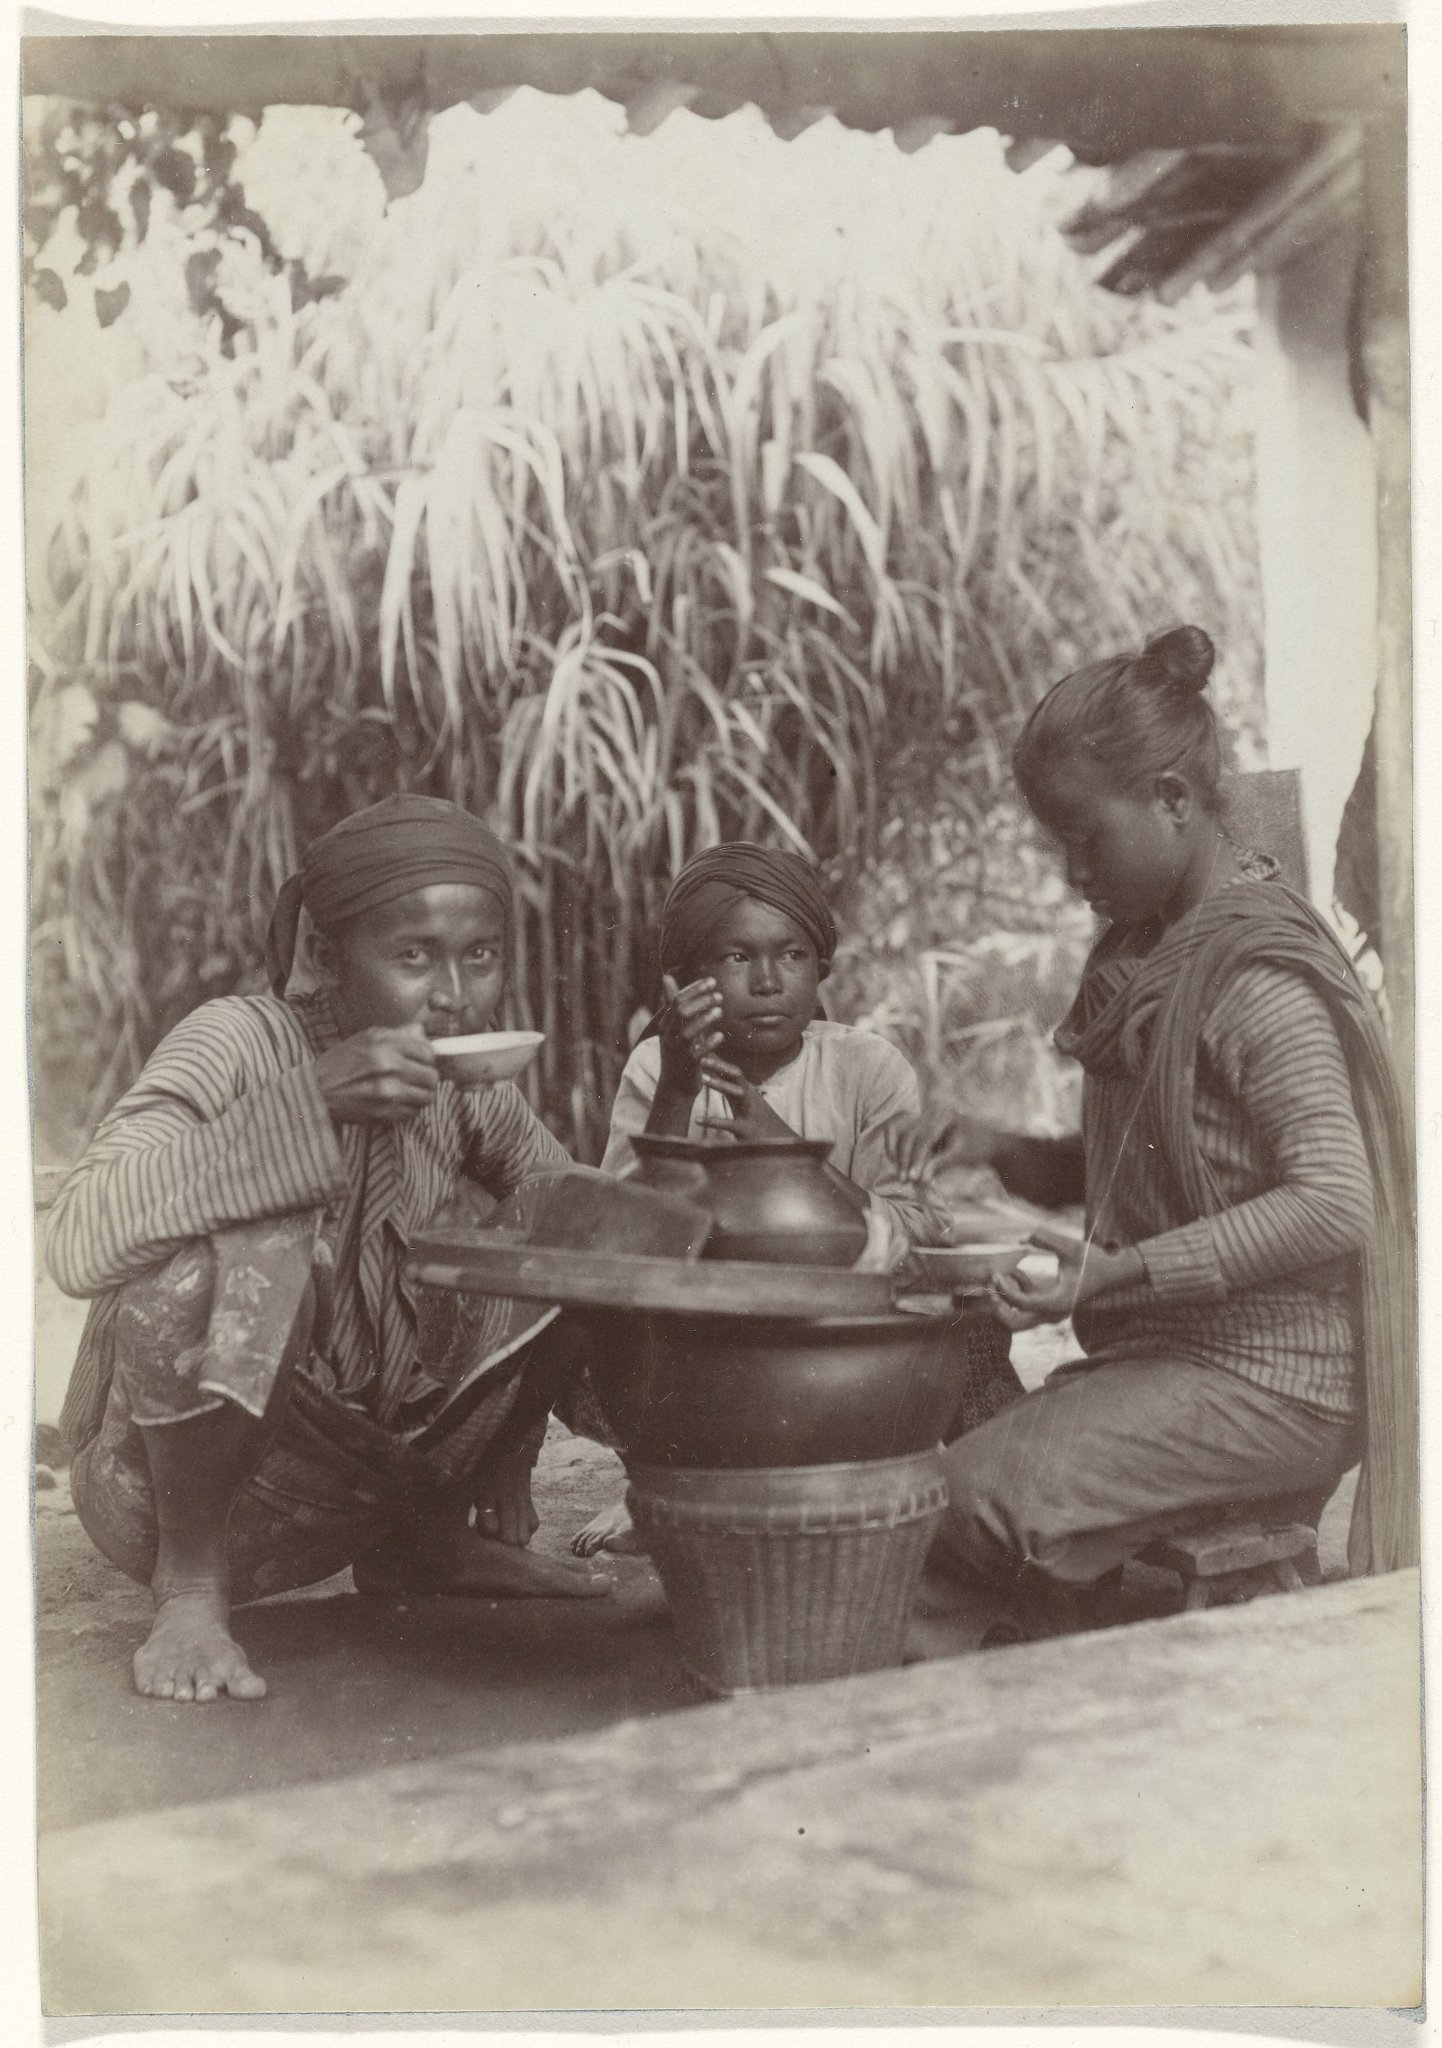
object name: photograph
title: Koelies eten en drinken gehurkt tussen het werk door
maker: Anonymous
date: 1870-1890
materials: paper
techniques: albumen print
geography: java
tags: drinking, eating, java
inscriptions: inscription: ‘Typen/ van/ Java’